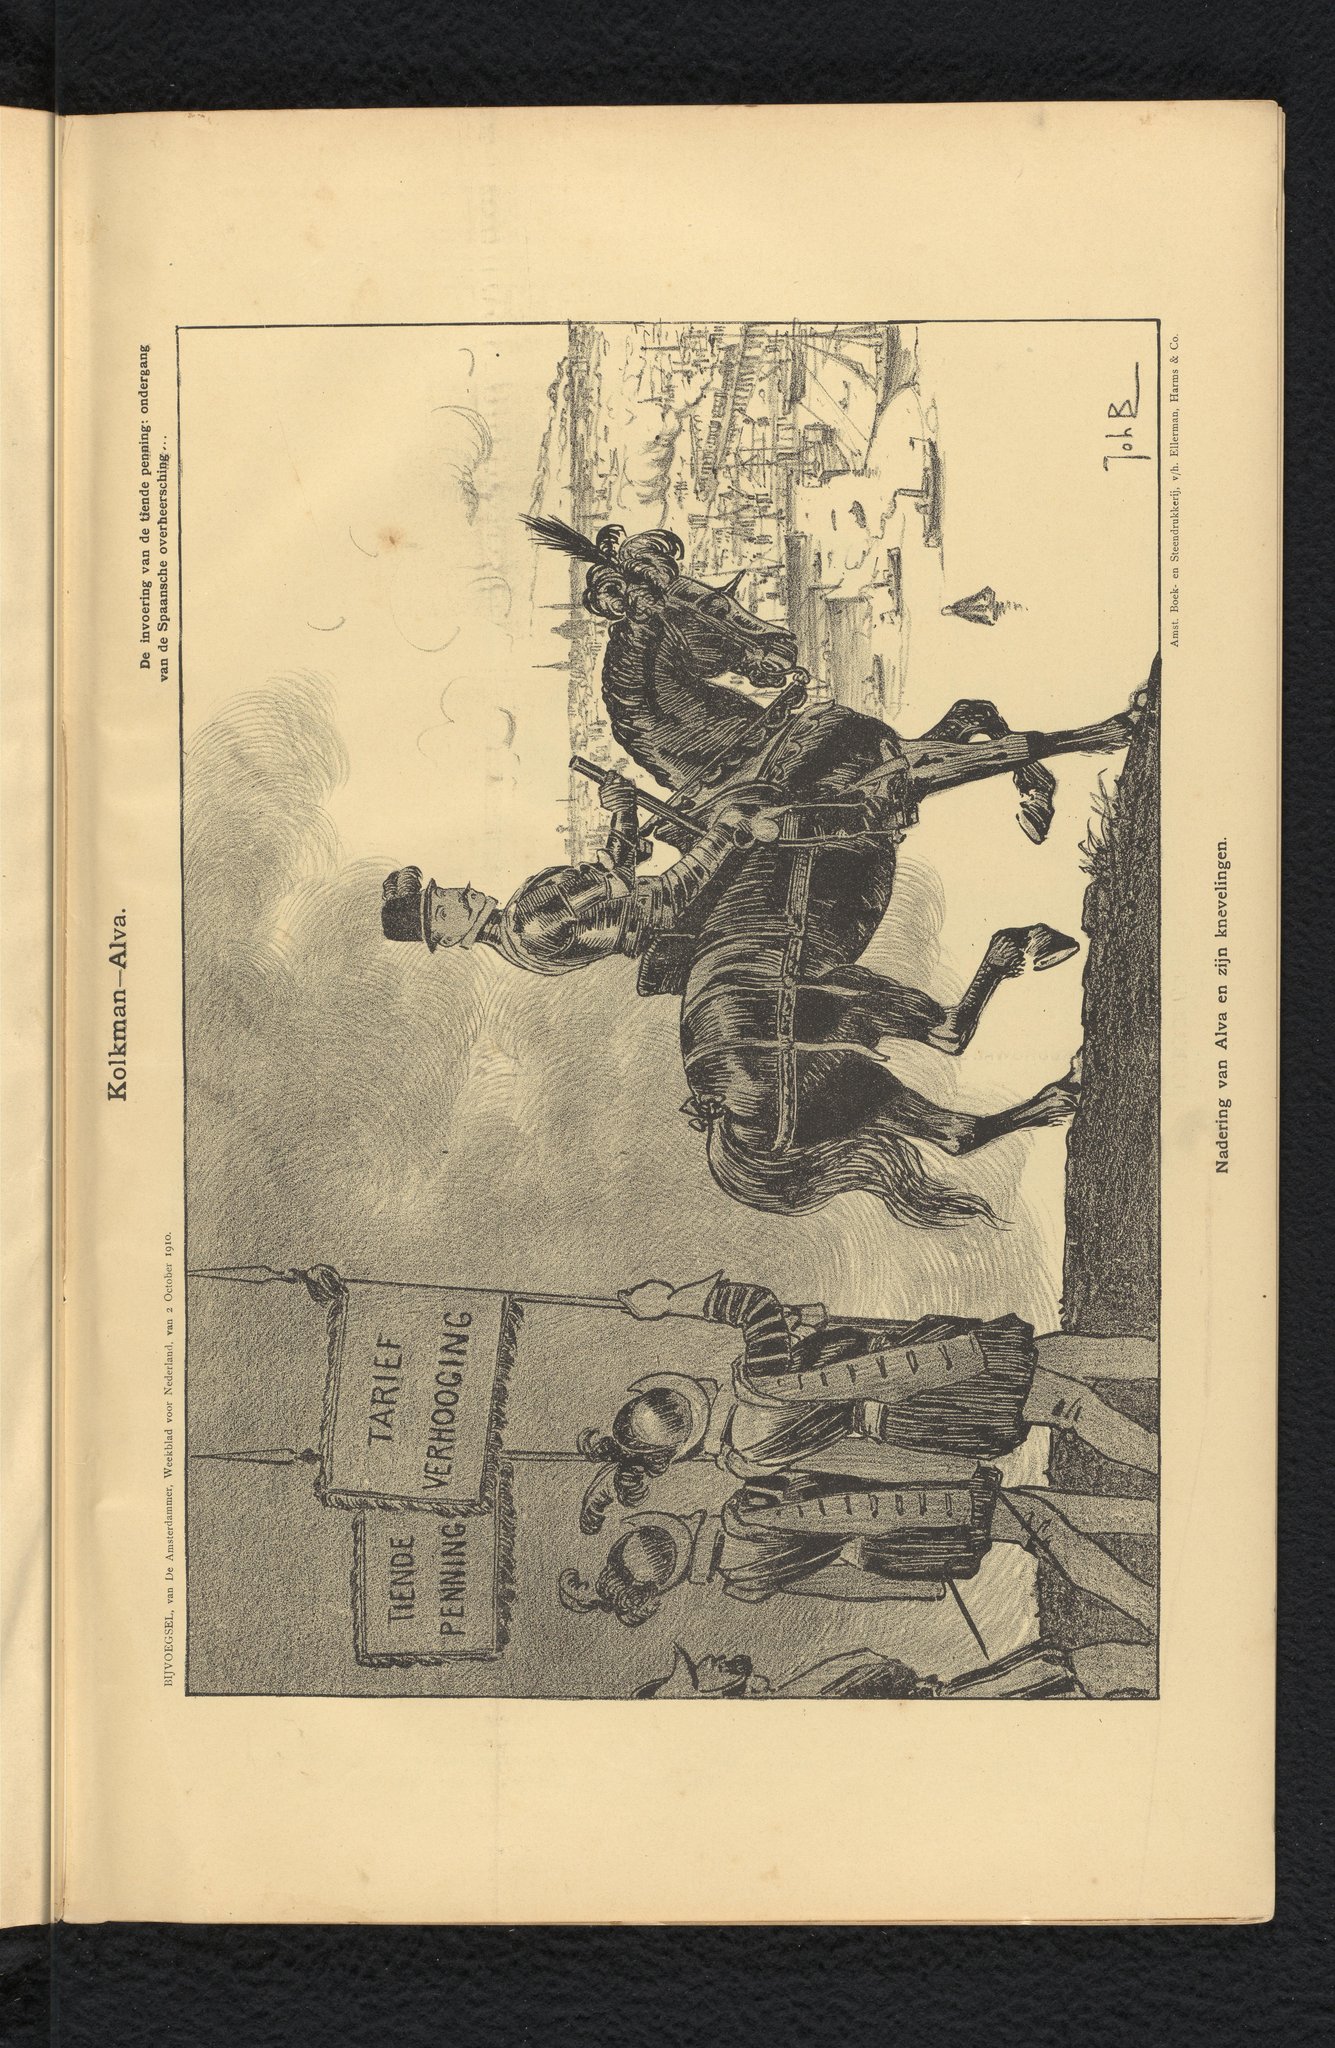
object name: cartoon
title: Kolkman-Alva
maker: johan braakensiek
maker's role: draughtsman, print maker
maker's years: 1858-1940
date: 1910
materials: paper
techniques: lithograph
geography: amsterdam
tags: fernando álvarez de toledo (3rd duke of alba), dordrecht, the hague, politician, riding a horse, ass, or mule; rider, horseman, tax collection, political caricatures and satires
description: Minister van Financiën Kolkman als de hertog van Alva die met zijn belastingmaatregelen (Tiende Penning) Nederland binnentrekt.